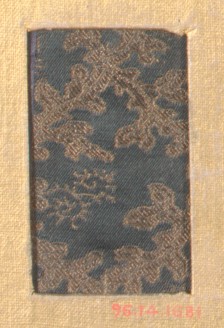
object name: piece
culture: japanese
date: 1701-1900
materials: silk